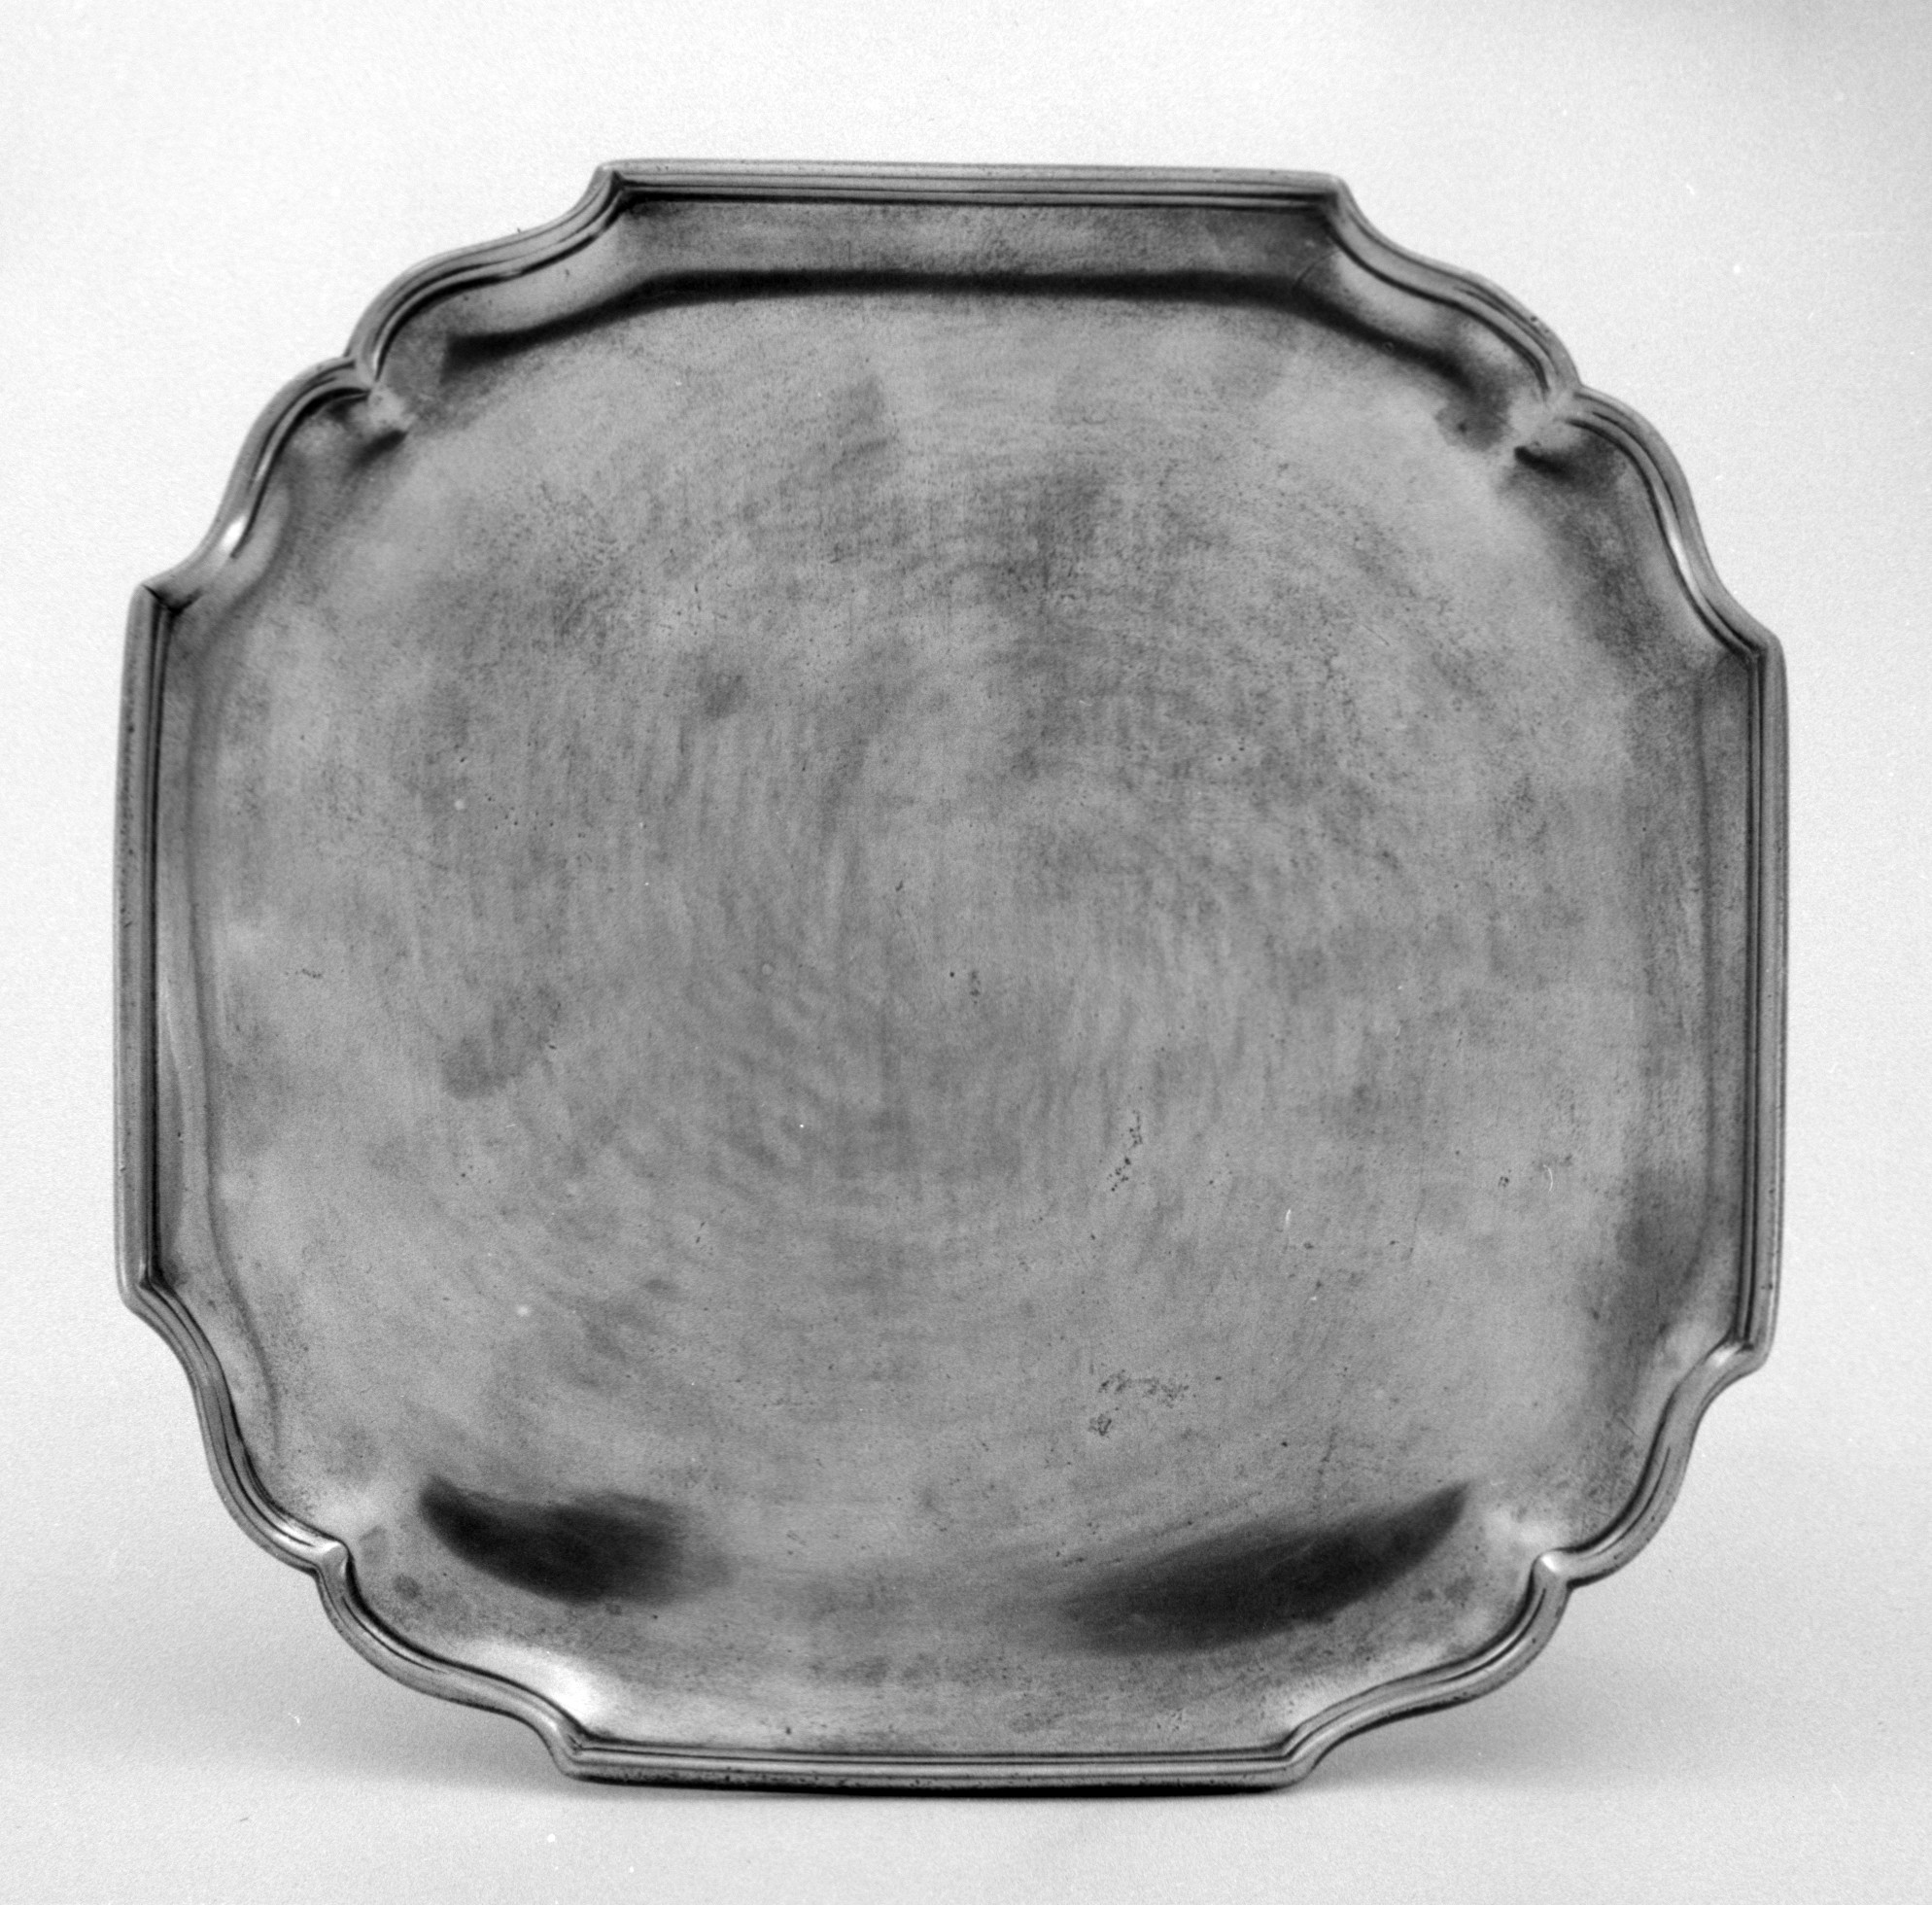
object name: salver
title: Square salver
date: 1735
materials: pewter